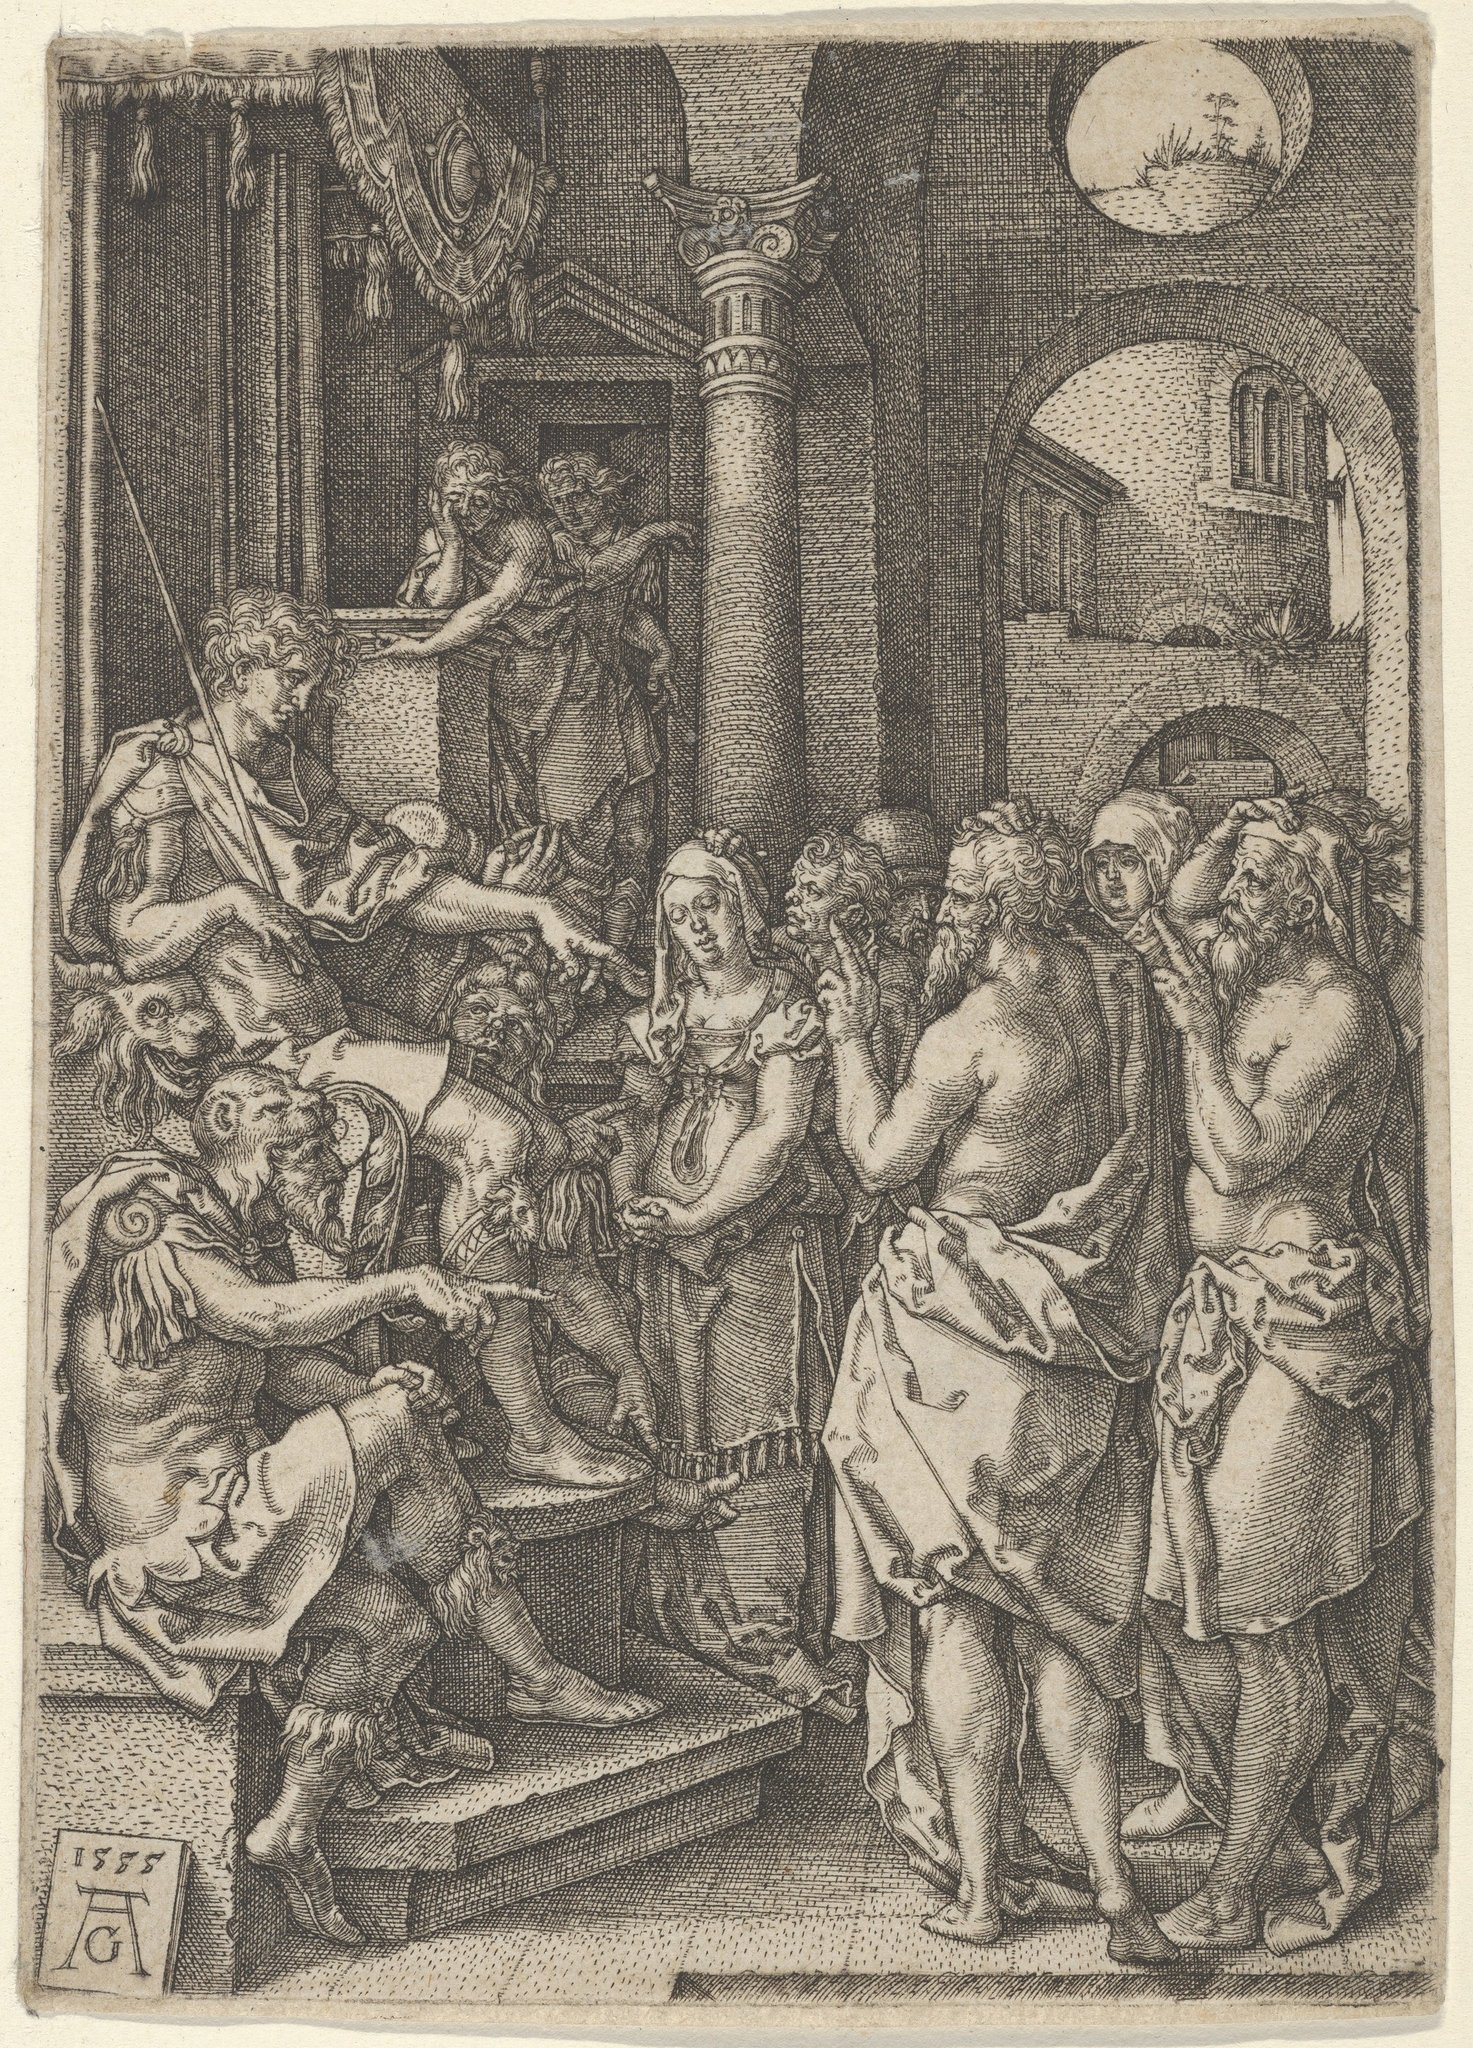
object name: print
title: Susanna Accused of Adultery, from The Story of Susanna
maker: heinrich aldegrever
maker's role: artist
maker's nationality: german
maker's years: 1502-1561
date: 1555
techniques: engraving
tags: men,women